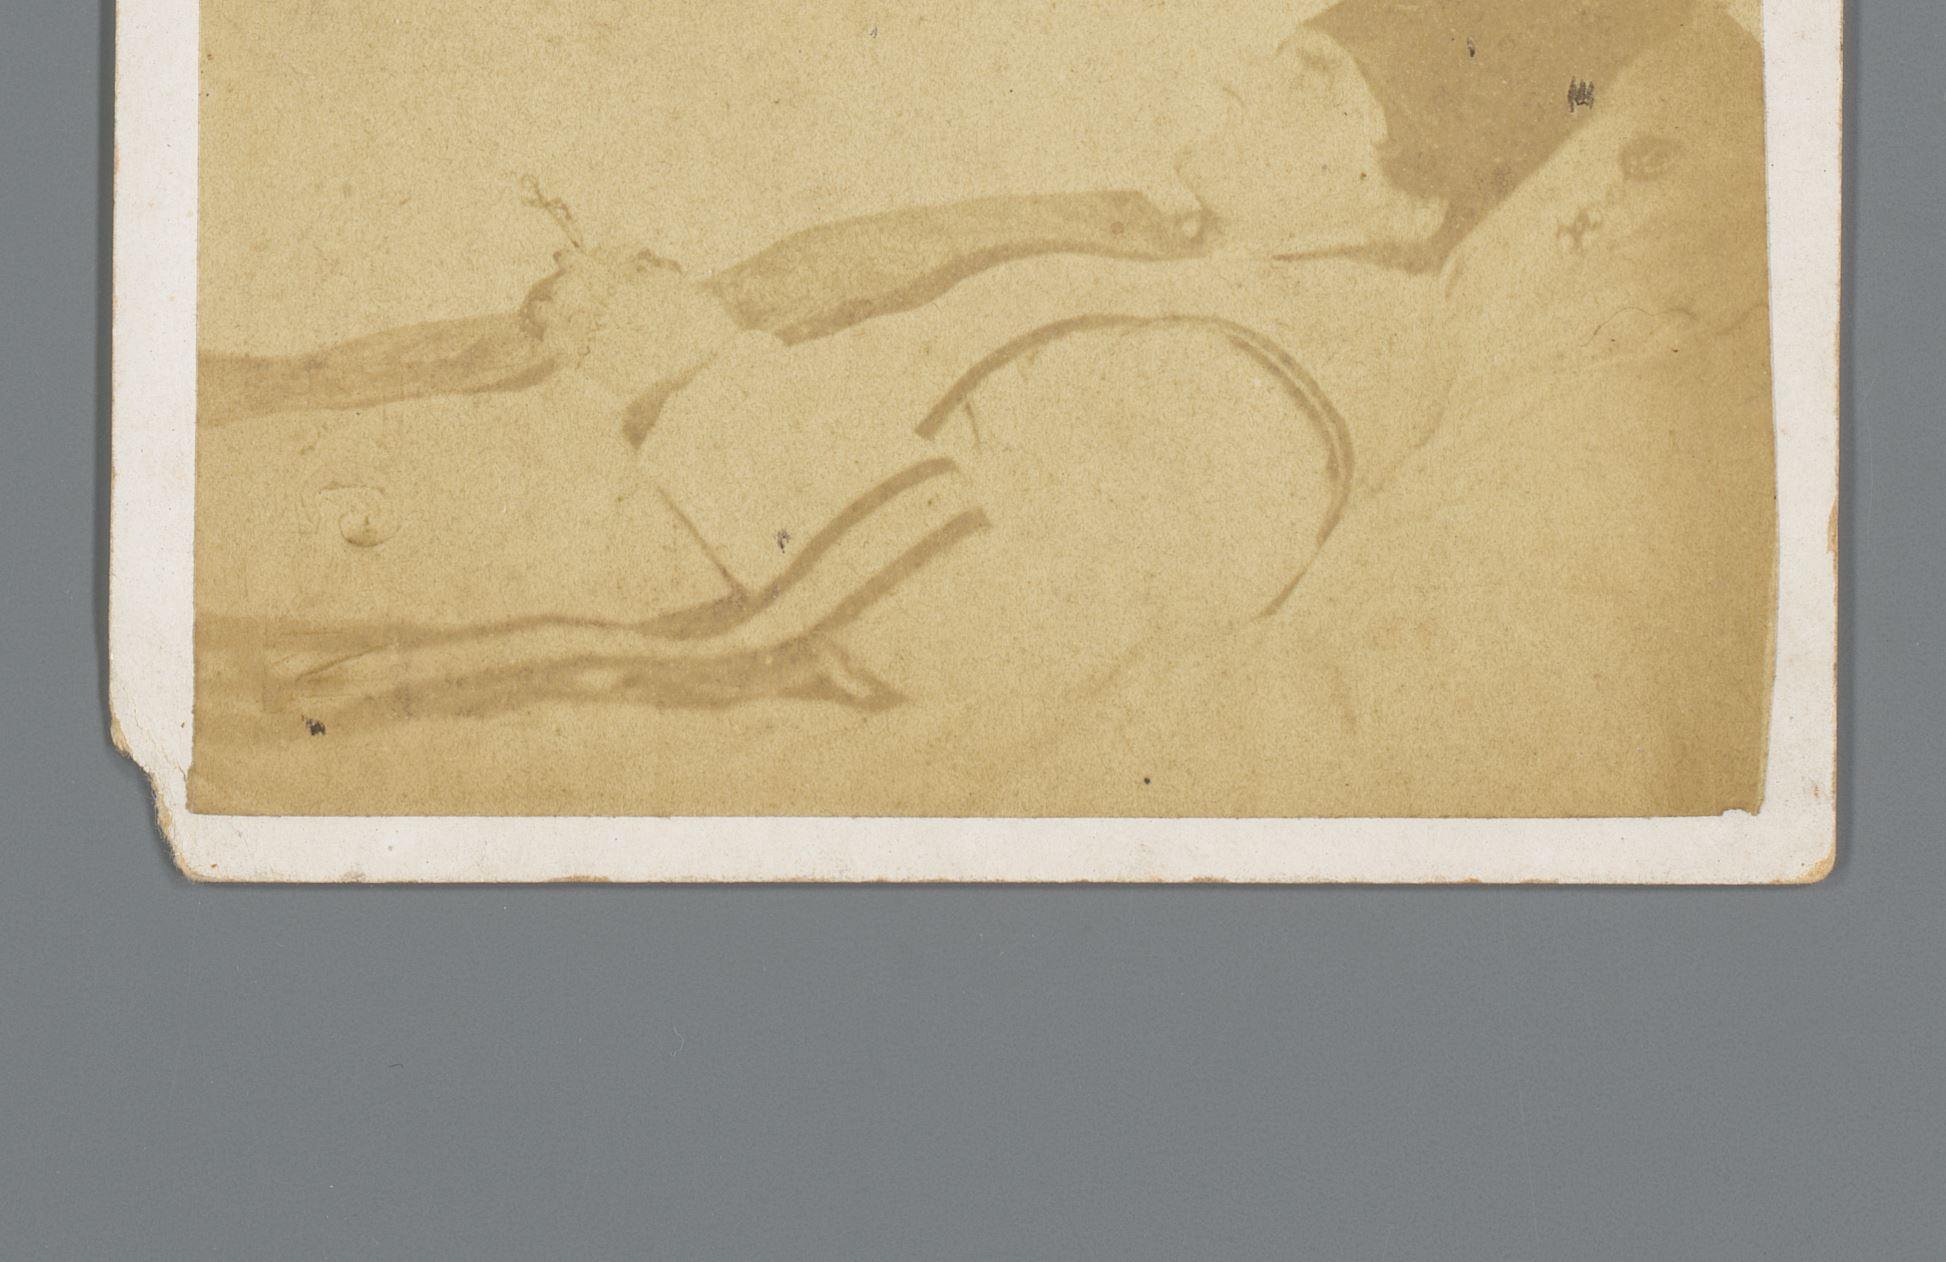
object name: photograph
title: Post-mortemportret van een onbekende geestelijke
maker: antoni verryck-fleetwood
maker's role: fotograaf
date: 1863-1864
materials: cardboard, paper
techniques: albumen print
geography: turnhout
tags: organization, functionaries and dignitaries in roman catholic church; clergy in general